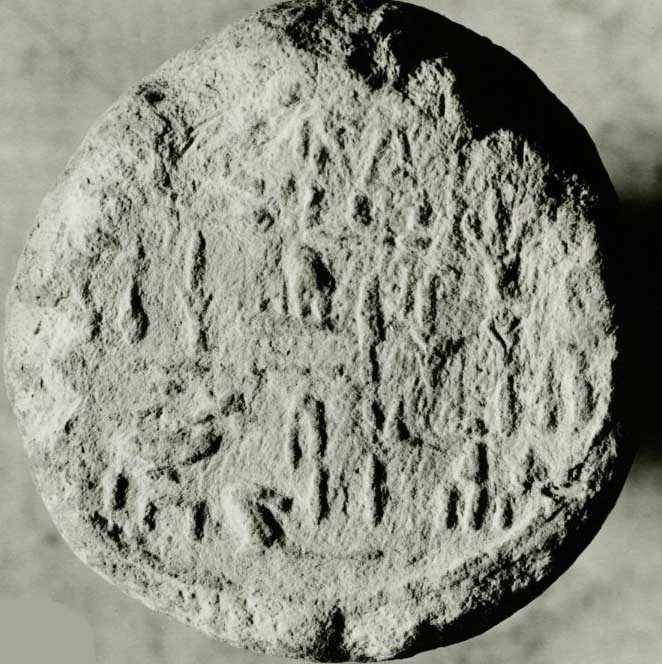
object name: cone, circular impression, userhat, royal scribe, account, cattle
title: Funerary Cone of the Royal Scribe Userhat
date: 1550-1295 BCE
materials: pottery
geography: egypt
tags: hieroglyphs